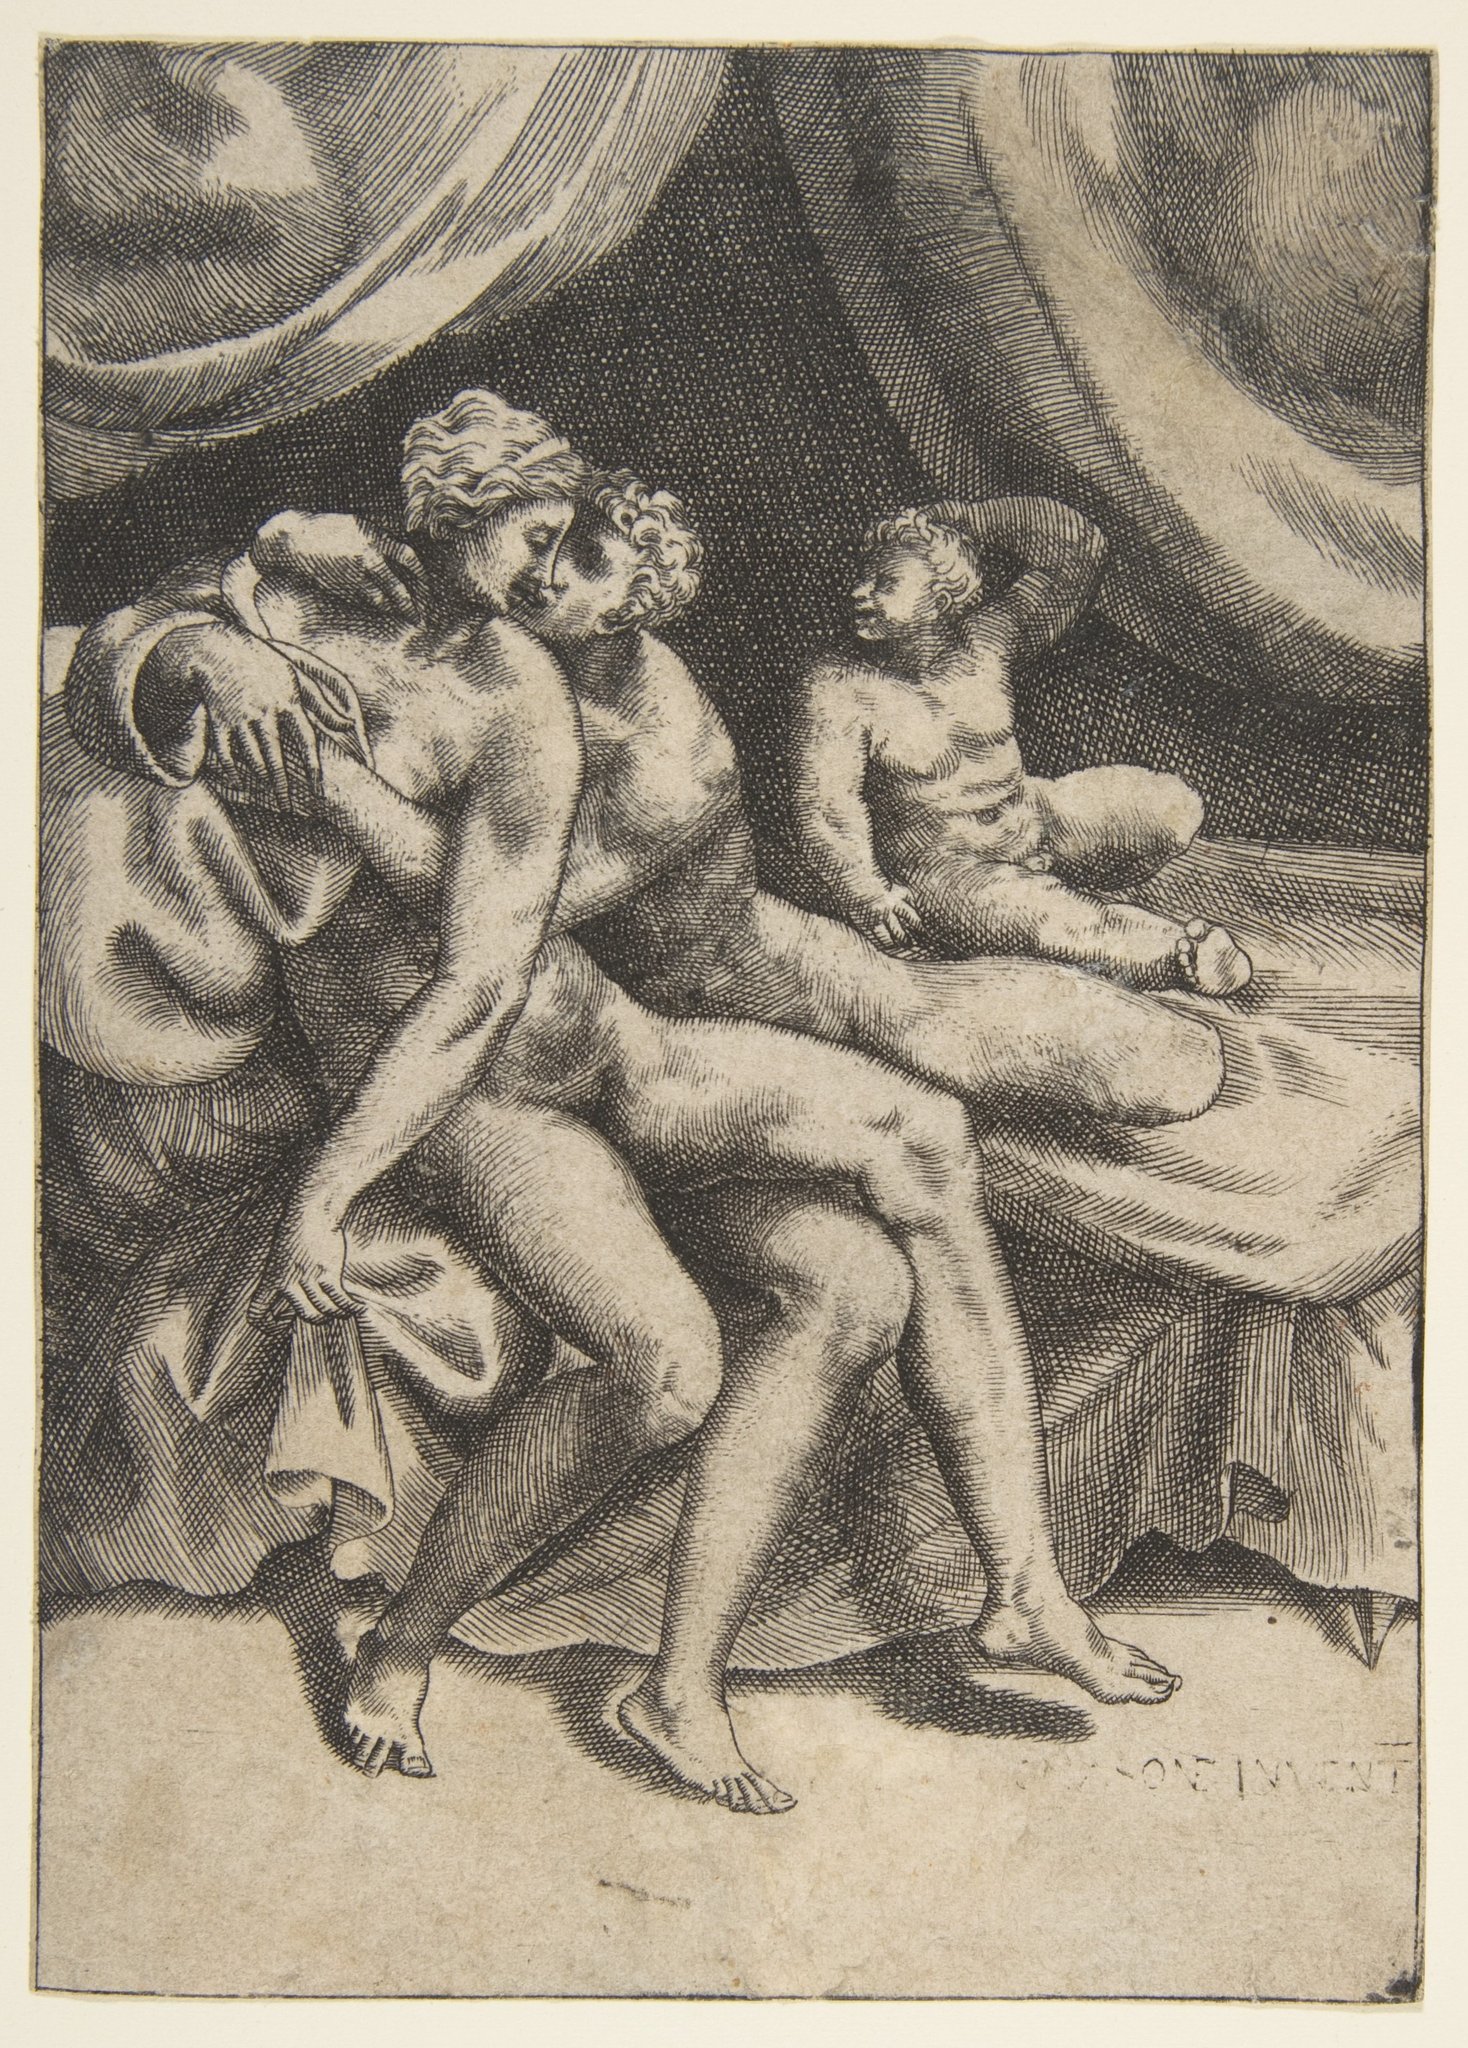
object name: print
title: Two lovers on a bed, from "The Loves of the Gods"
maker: giulio bonasone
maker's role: artist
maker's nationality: italian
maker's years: 1510-1576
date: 1531-1576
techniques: engraving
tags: children,men,lovers,women,beds